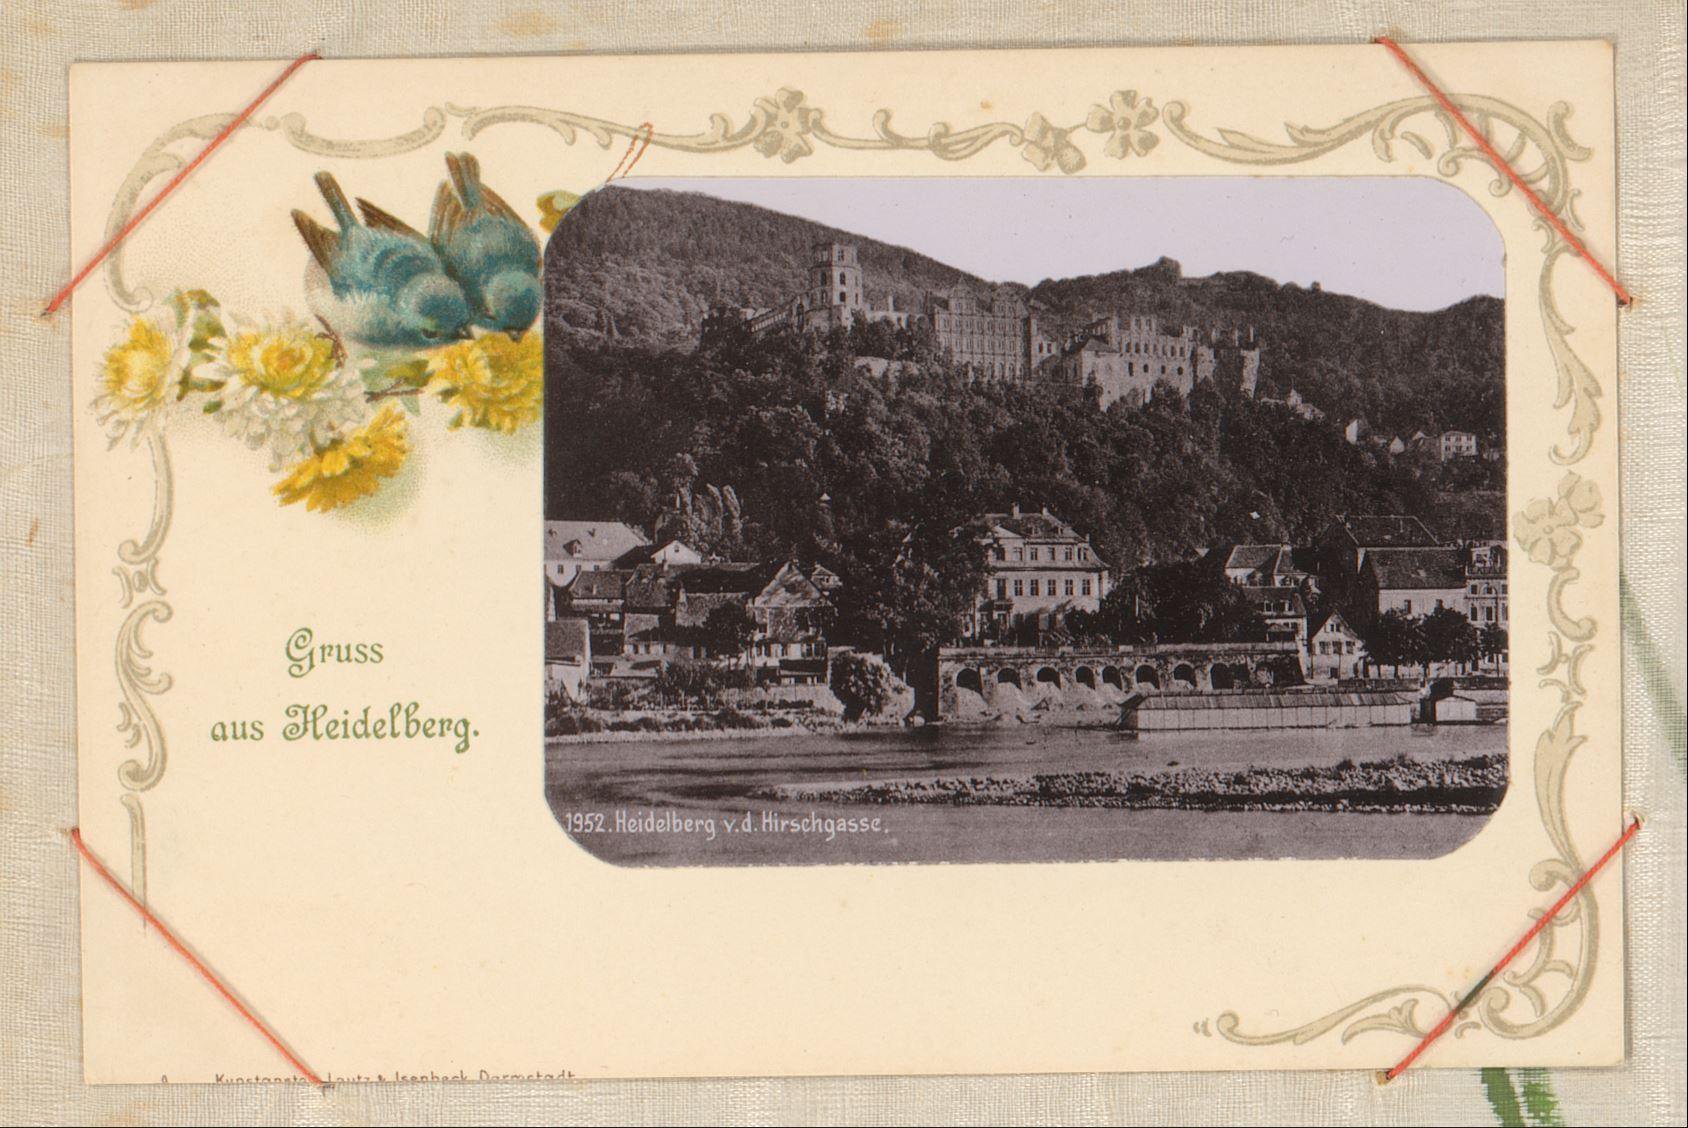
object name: ansichtkaart, prentbriefkaart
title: Heidelberg v.d. Hirschgasse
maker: Anonymous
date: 1880-1910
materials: cardboard, paint, paper, silk, textile, watercolor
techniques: brush, chromolithography, photograph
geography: heidelberg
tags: city-view in general; 'veduta'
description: Deze prent maakt deel uit van een album.